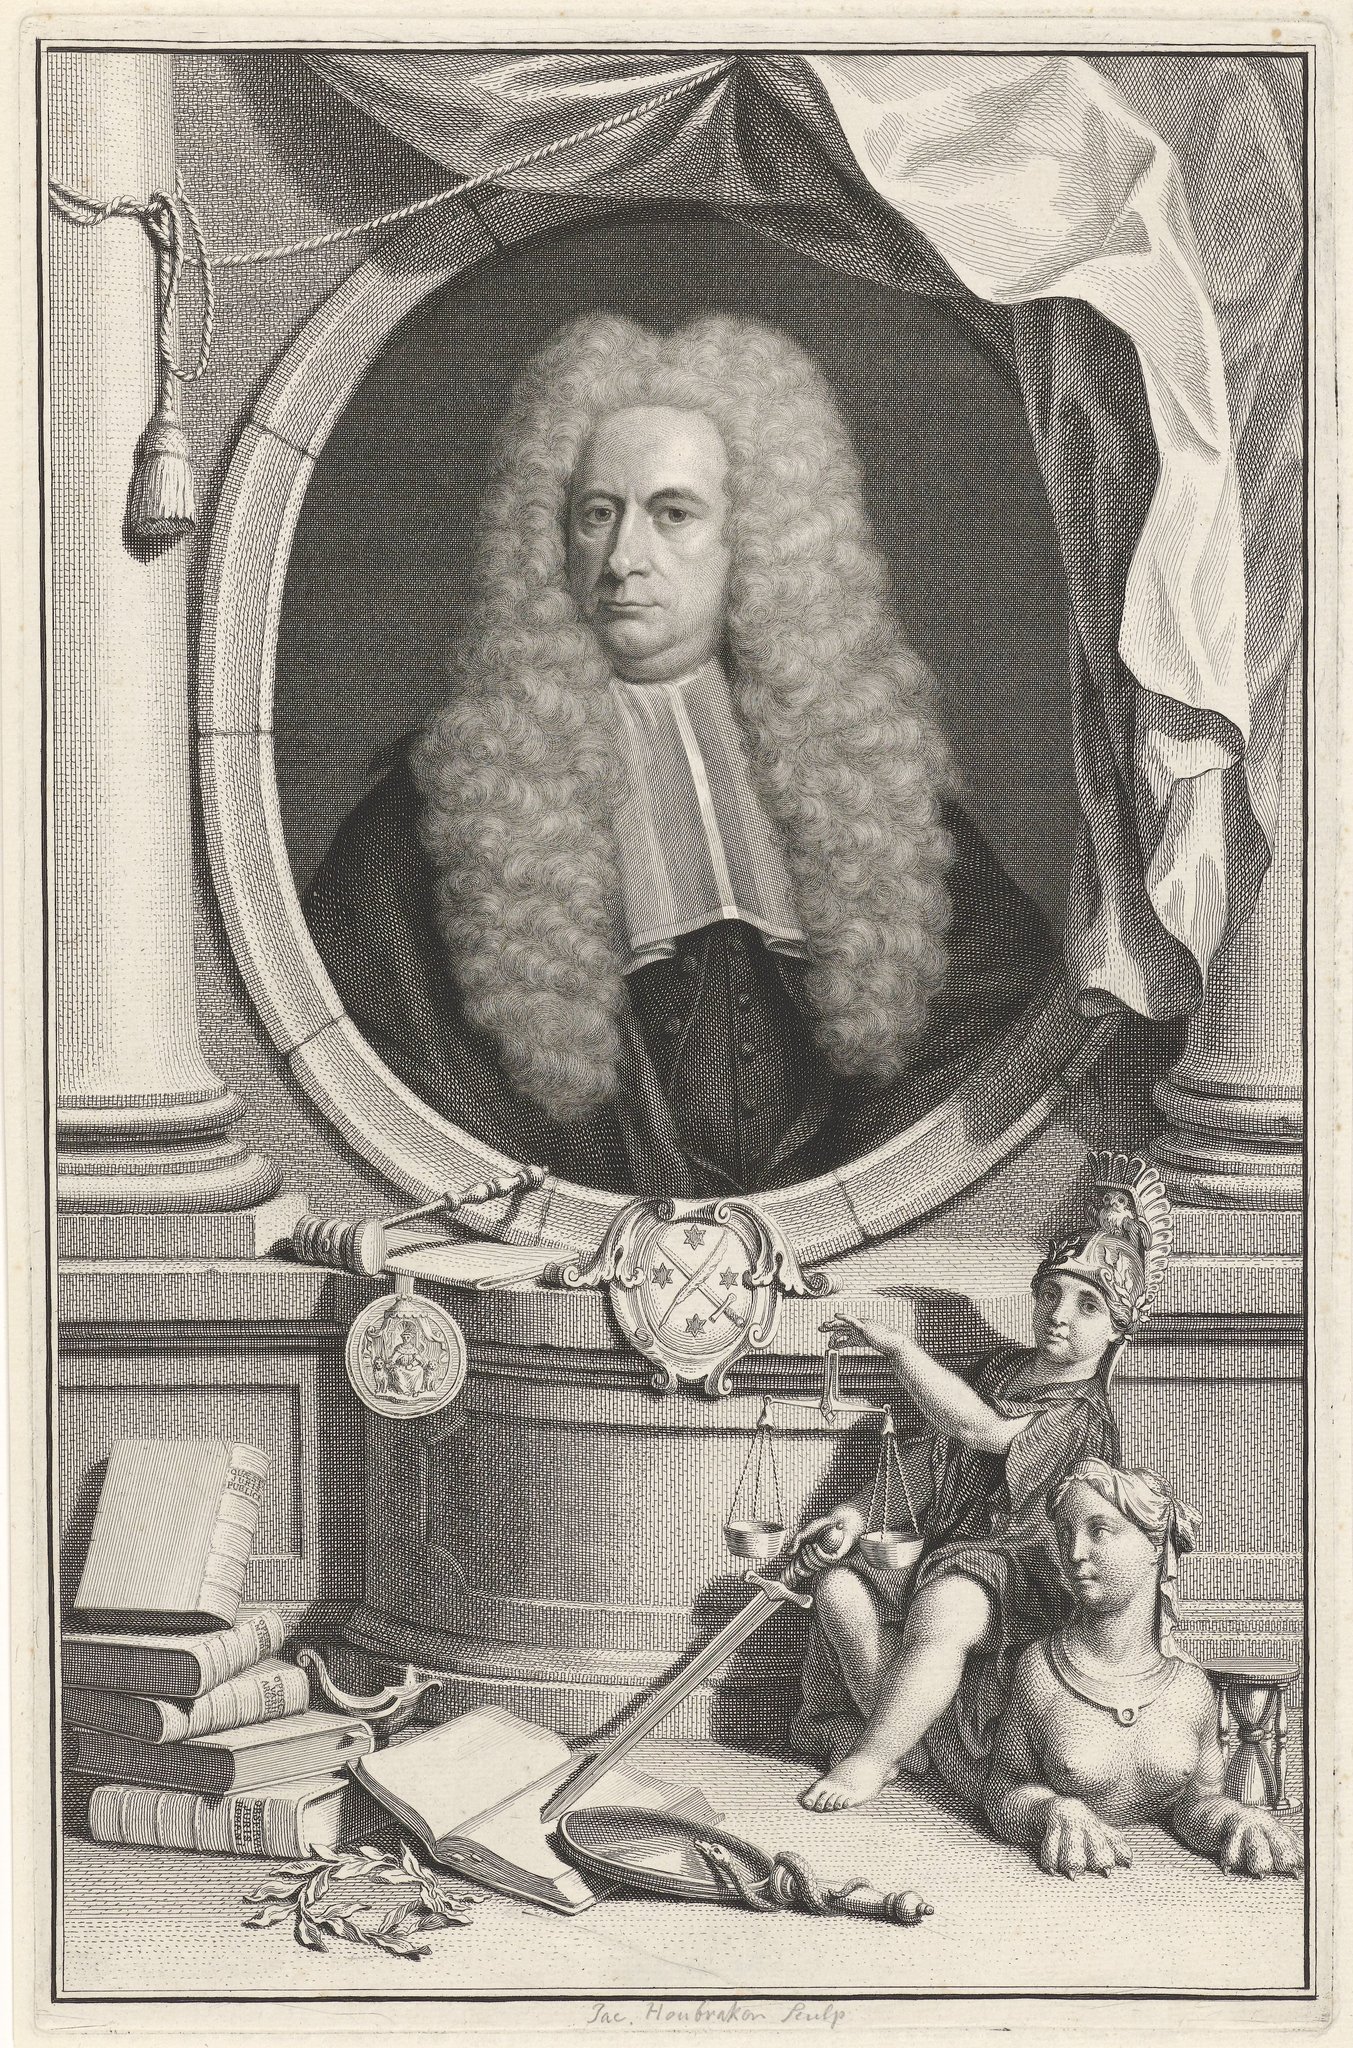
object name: print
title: Portret van Cornelis van Bynkershoek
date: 1741-1743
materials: paper, pencil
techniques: engraving, etching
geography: amsterdam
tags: sphinx (lion/woman); 'sfinge' (ripa), symbols and allegories of jurisprudence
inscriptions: name: ‘Jac. Houbraken Sculp.’, collector's mark: Lugt 2228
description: Buste van Cornelis van Bynkershoek in een ovaal, tussen twee zuilen. Rechts een gordijn en op de voorgrond de personificatie van de rechtspraak, gezeten op de rug van een sfinx. Links op de voorgrond boeken over de rechtspraak, een lauwerkrans en een spiegel met een slang rond het handvat. Onder het portret zijn wapen.